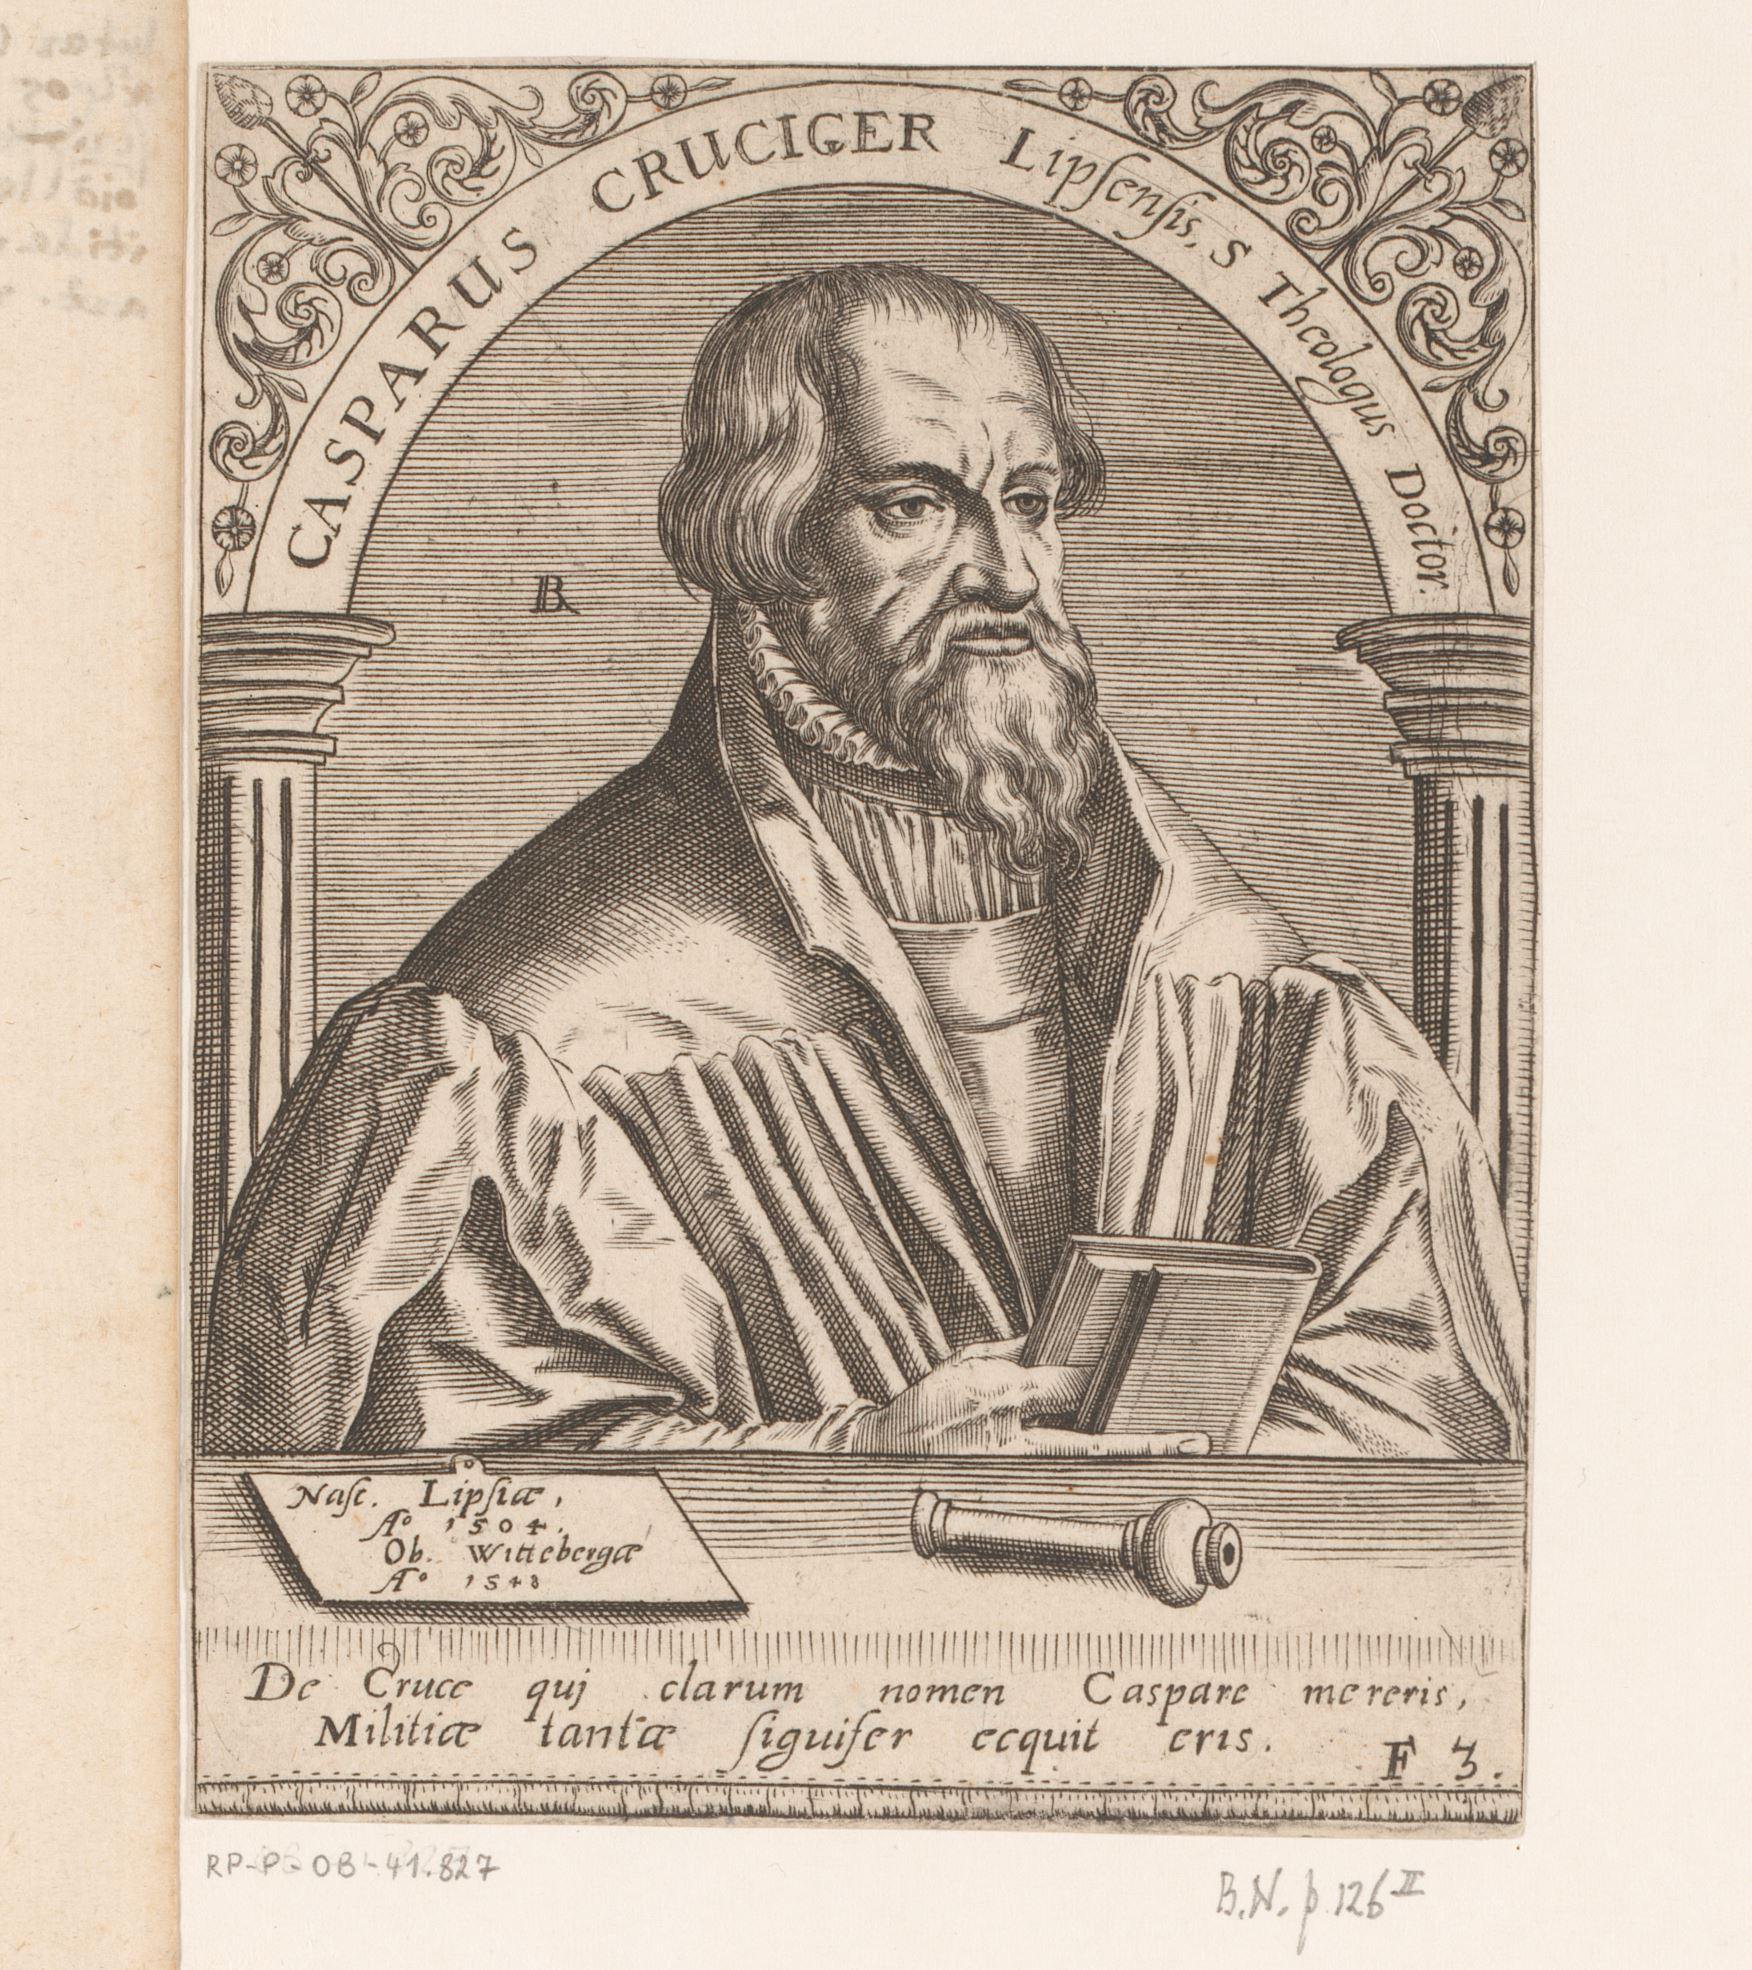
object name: print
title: Serie portretten van vijftiende- en zestiende-eeuwse geleerden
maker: robert boissard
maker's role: print maker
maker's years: 1570-1611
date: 1597-1599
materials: paper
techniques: engraving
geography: france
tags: historical persons, book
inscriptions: collector's mark: Lugt 2228